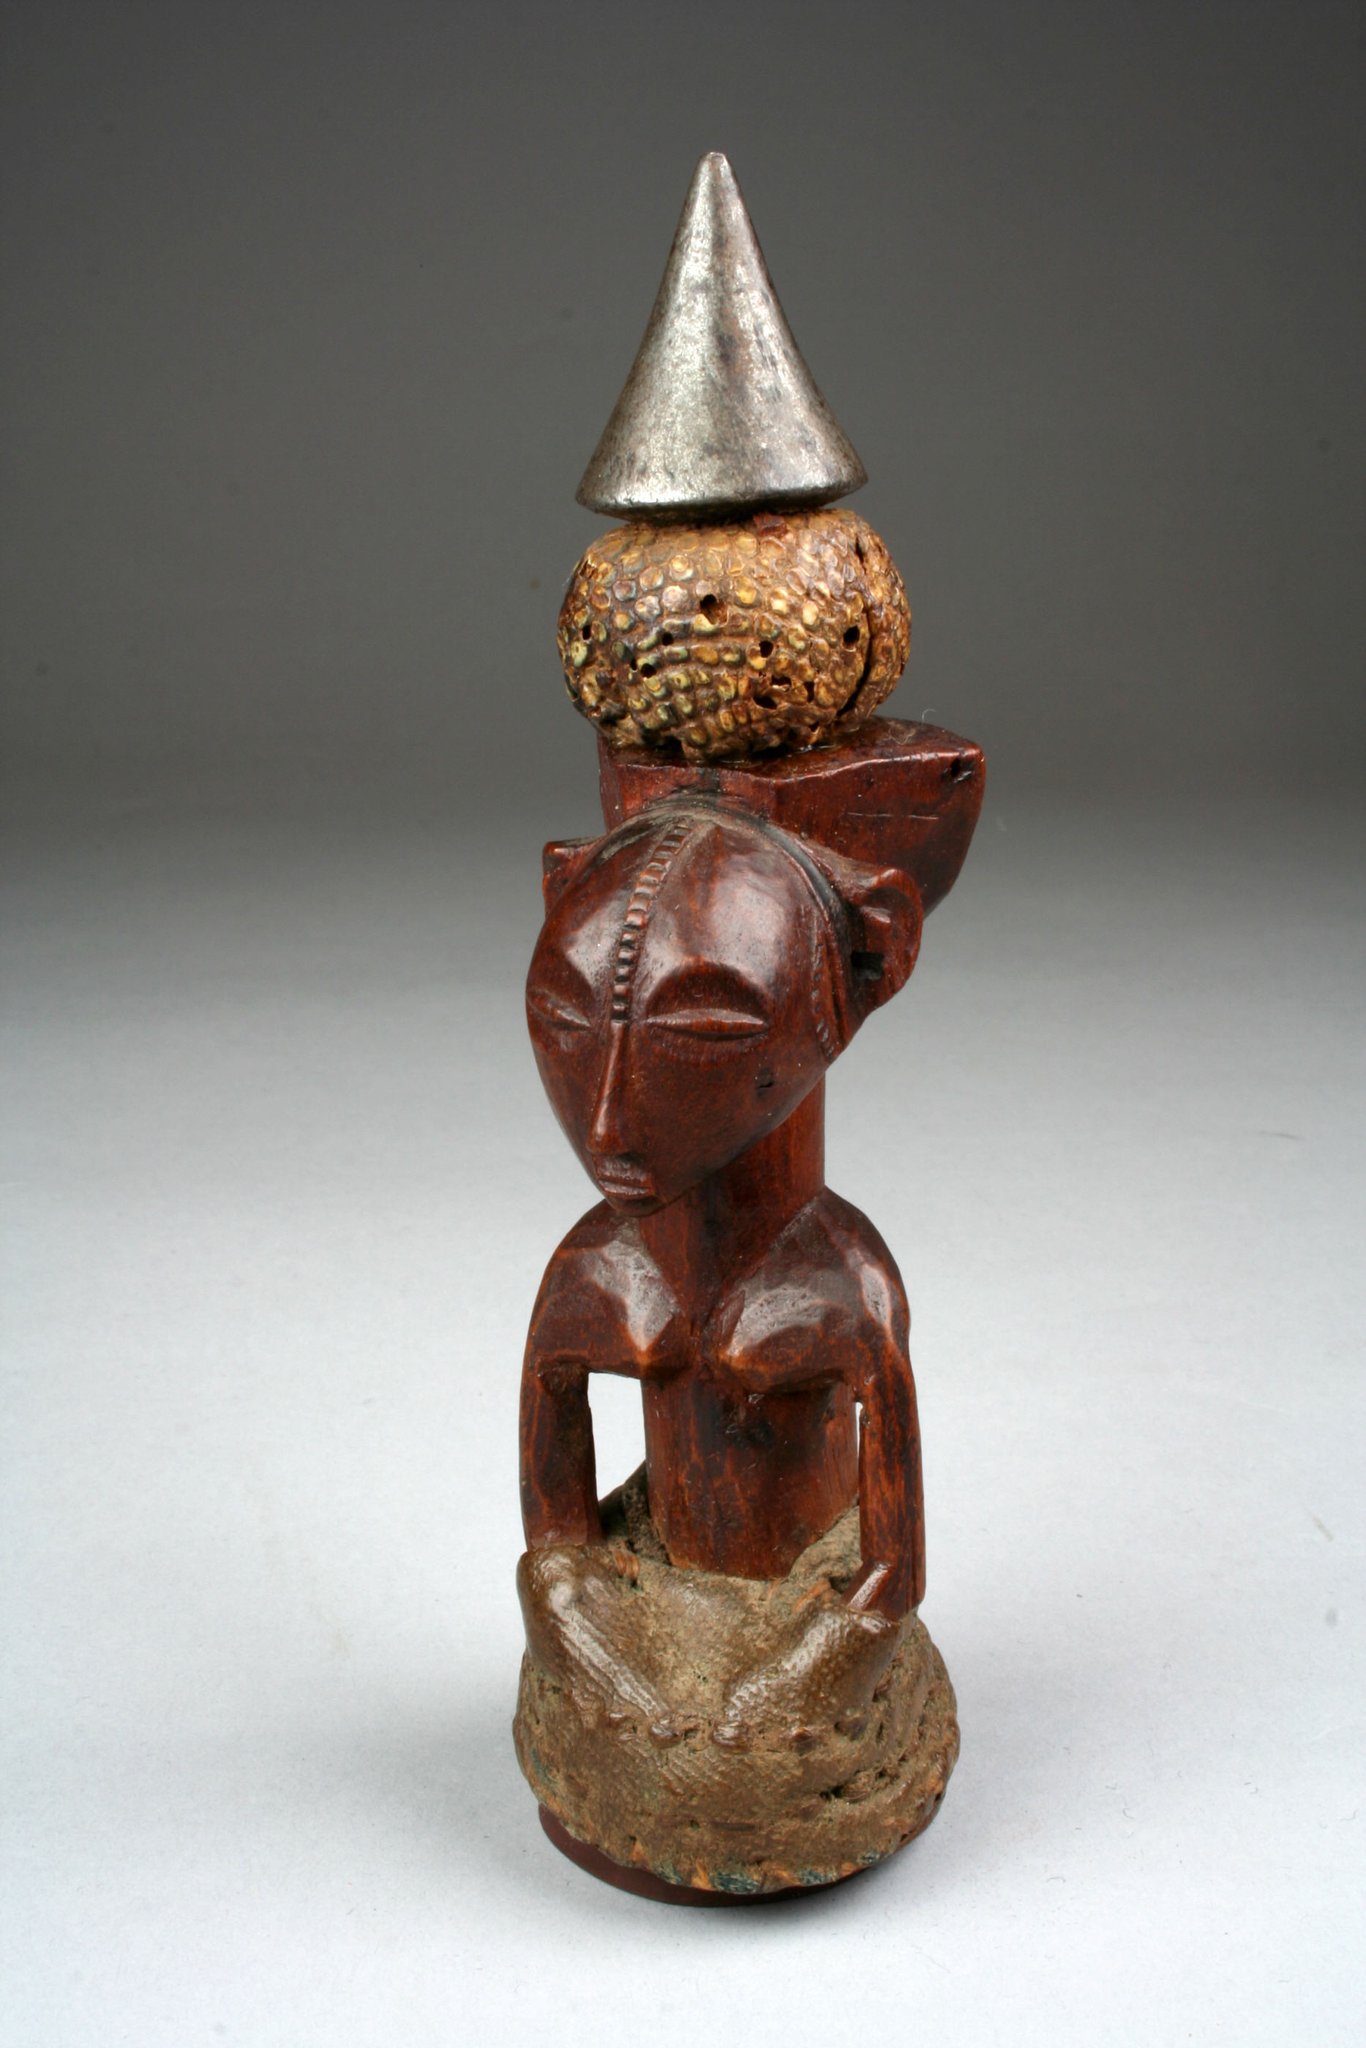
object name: female figure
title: Power Figure: Seated Female (Nkisi)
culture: kusu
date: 1801-1900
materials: textile, iron, skin, wood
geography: democratic republic of the congo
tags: women